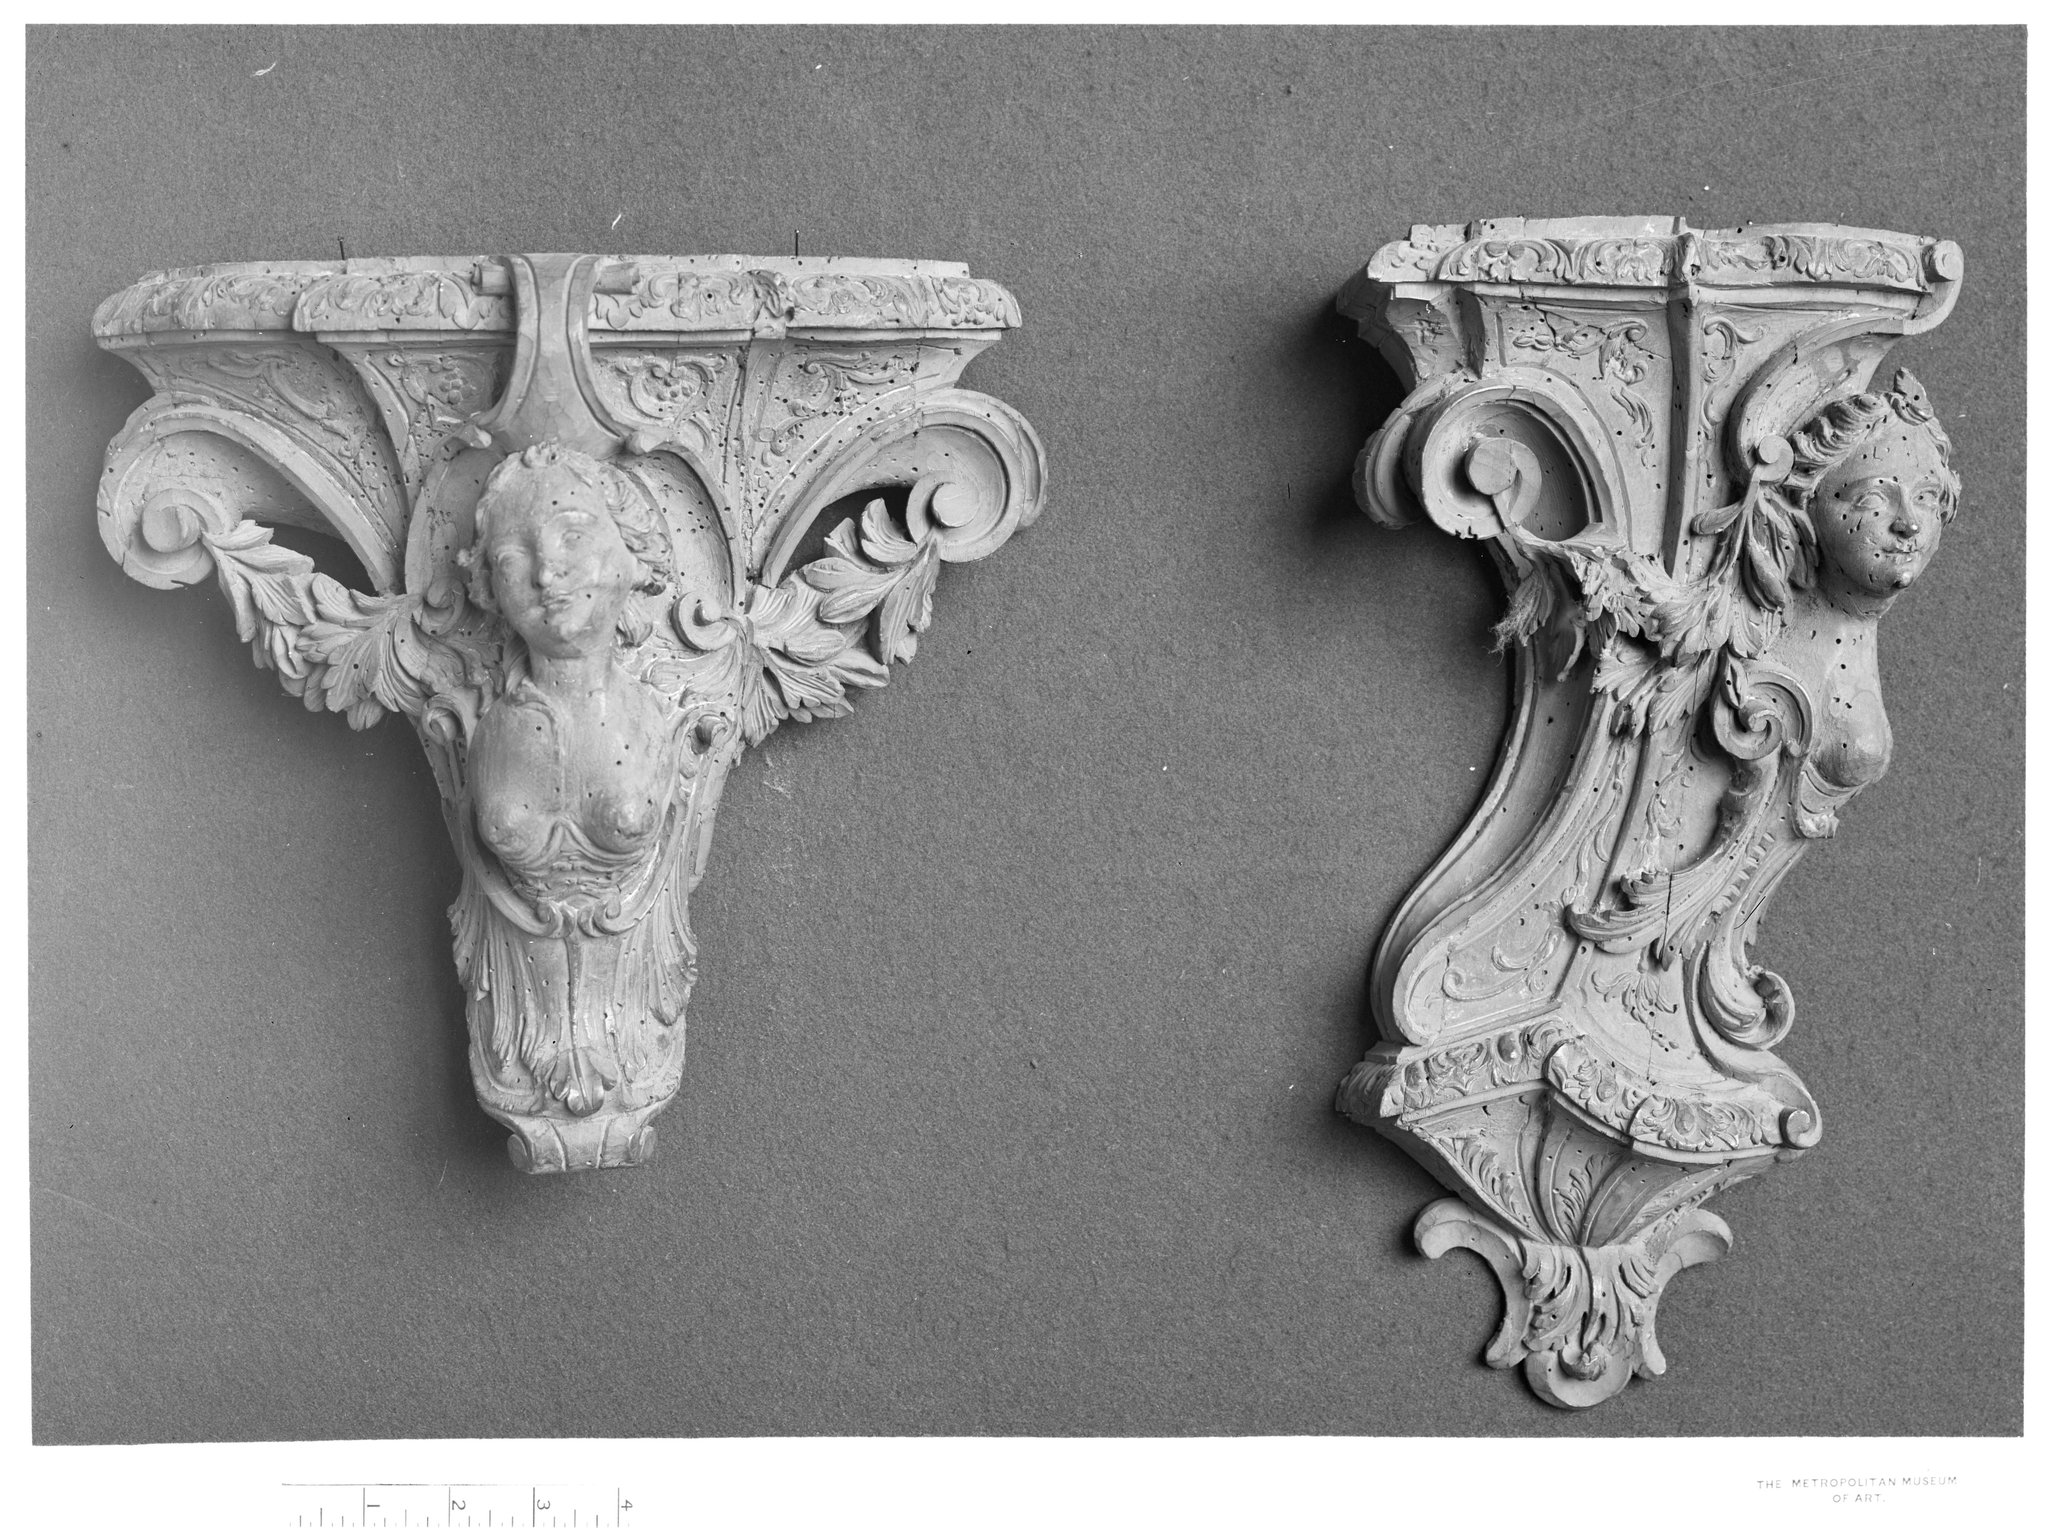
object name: console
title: Pair of consoles (consoles d'appliques)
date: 1701-1725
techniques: carving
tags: women